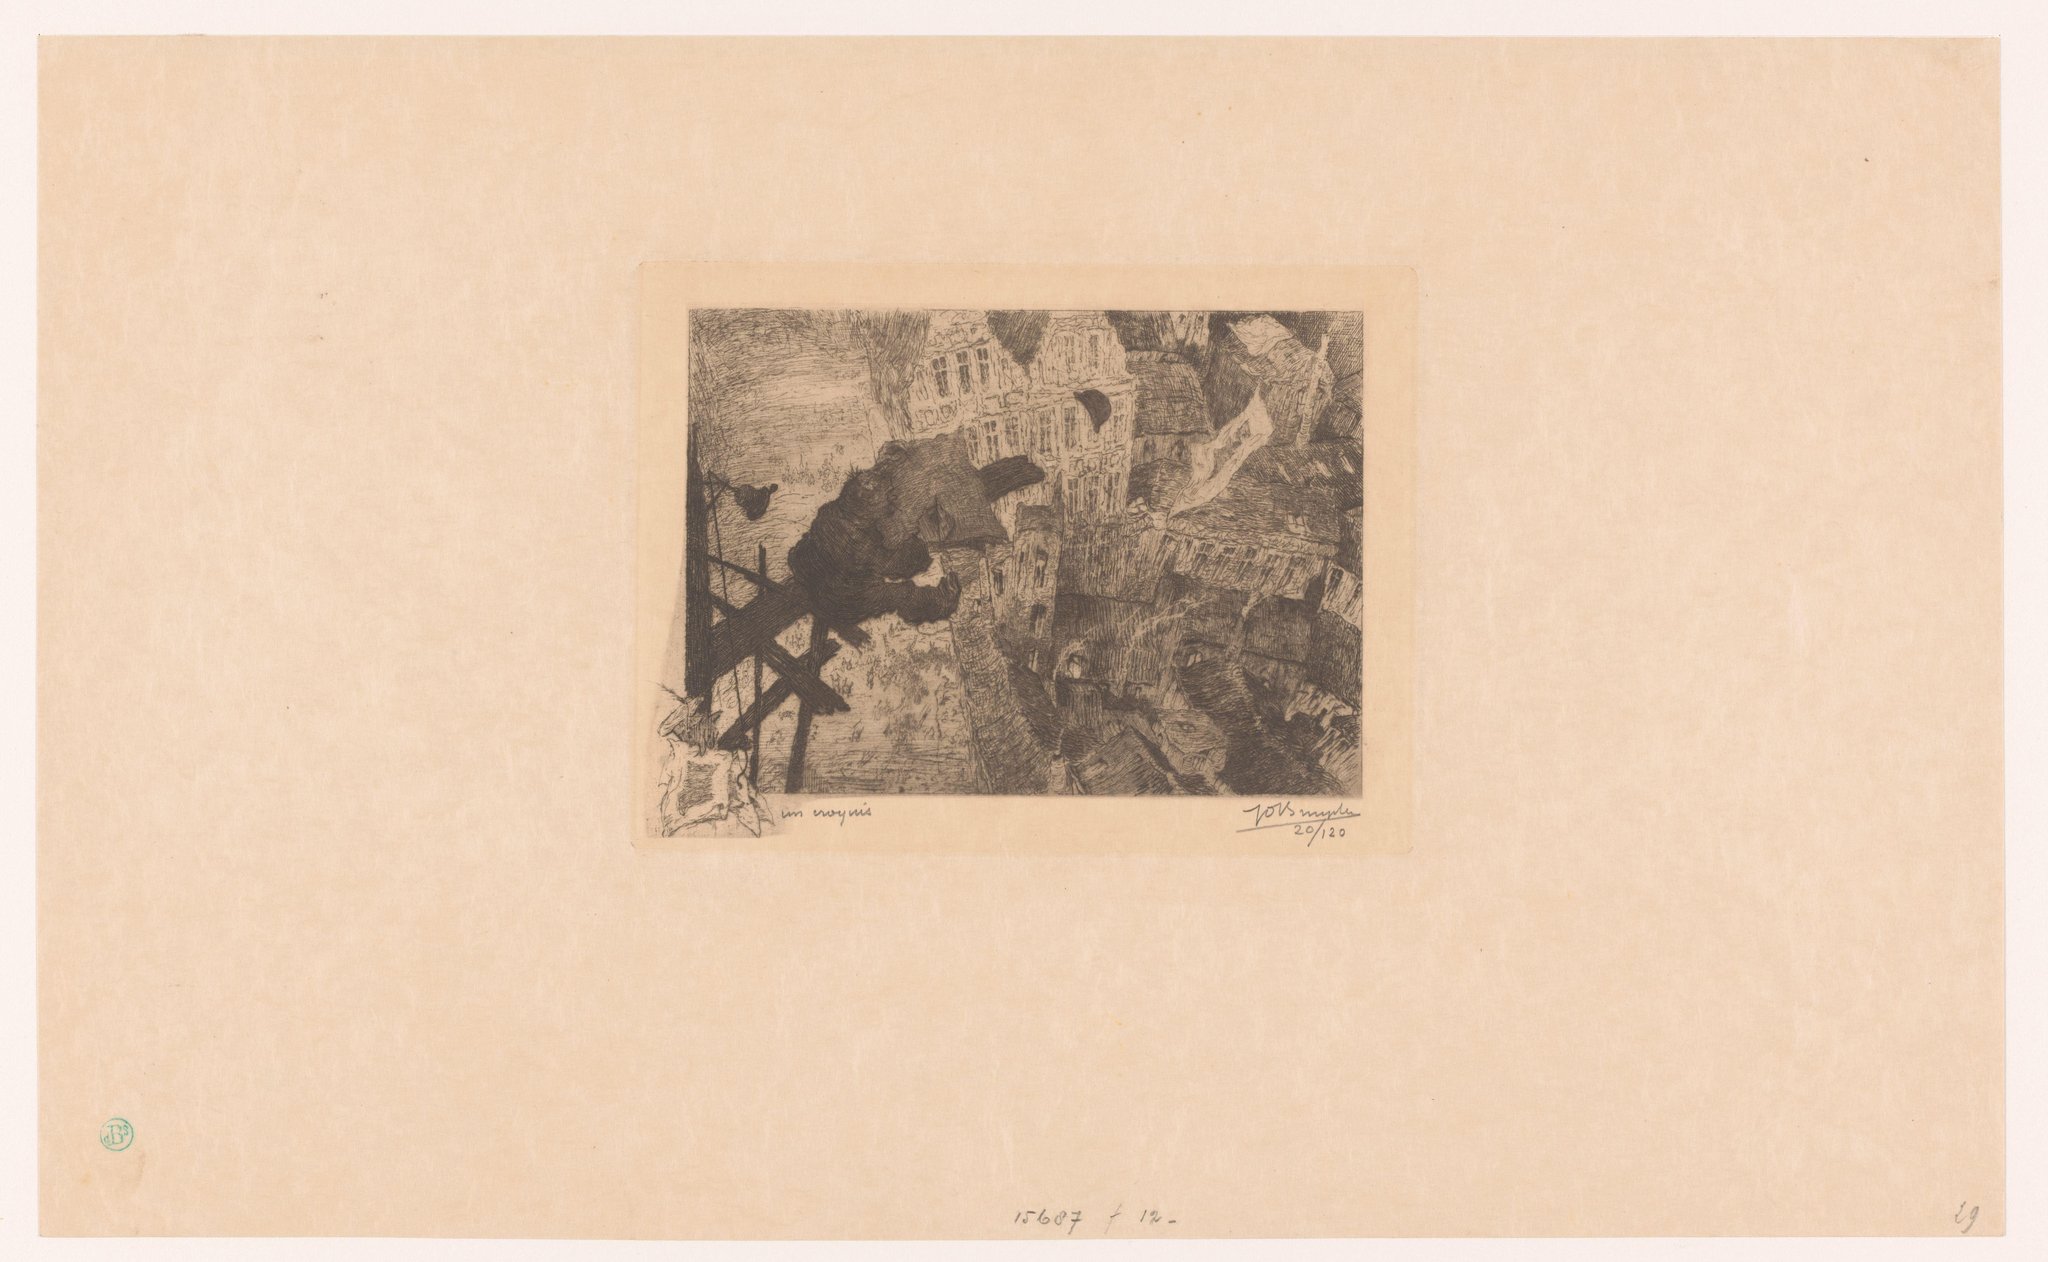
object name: print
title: Un croquis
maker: jules de bruycker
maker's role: print maker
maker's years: 1870-1945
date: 1914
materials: paper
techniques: etching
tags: drawing, sketch (+ artist at work)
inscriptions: collector's mark: Lugt 2228, collector's mark: Lugt 2760, collector's mark: Lugt 311b, collector's mark: Lugt 733